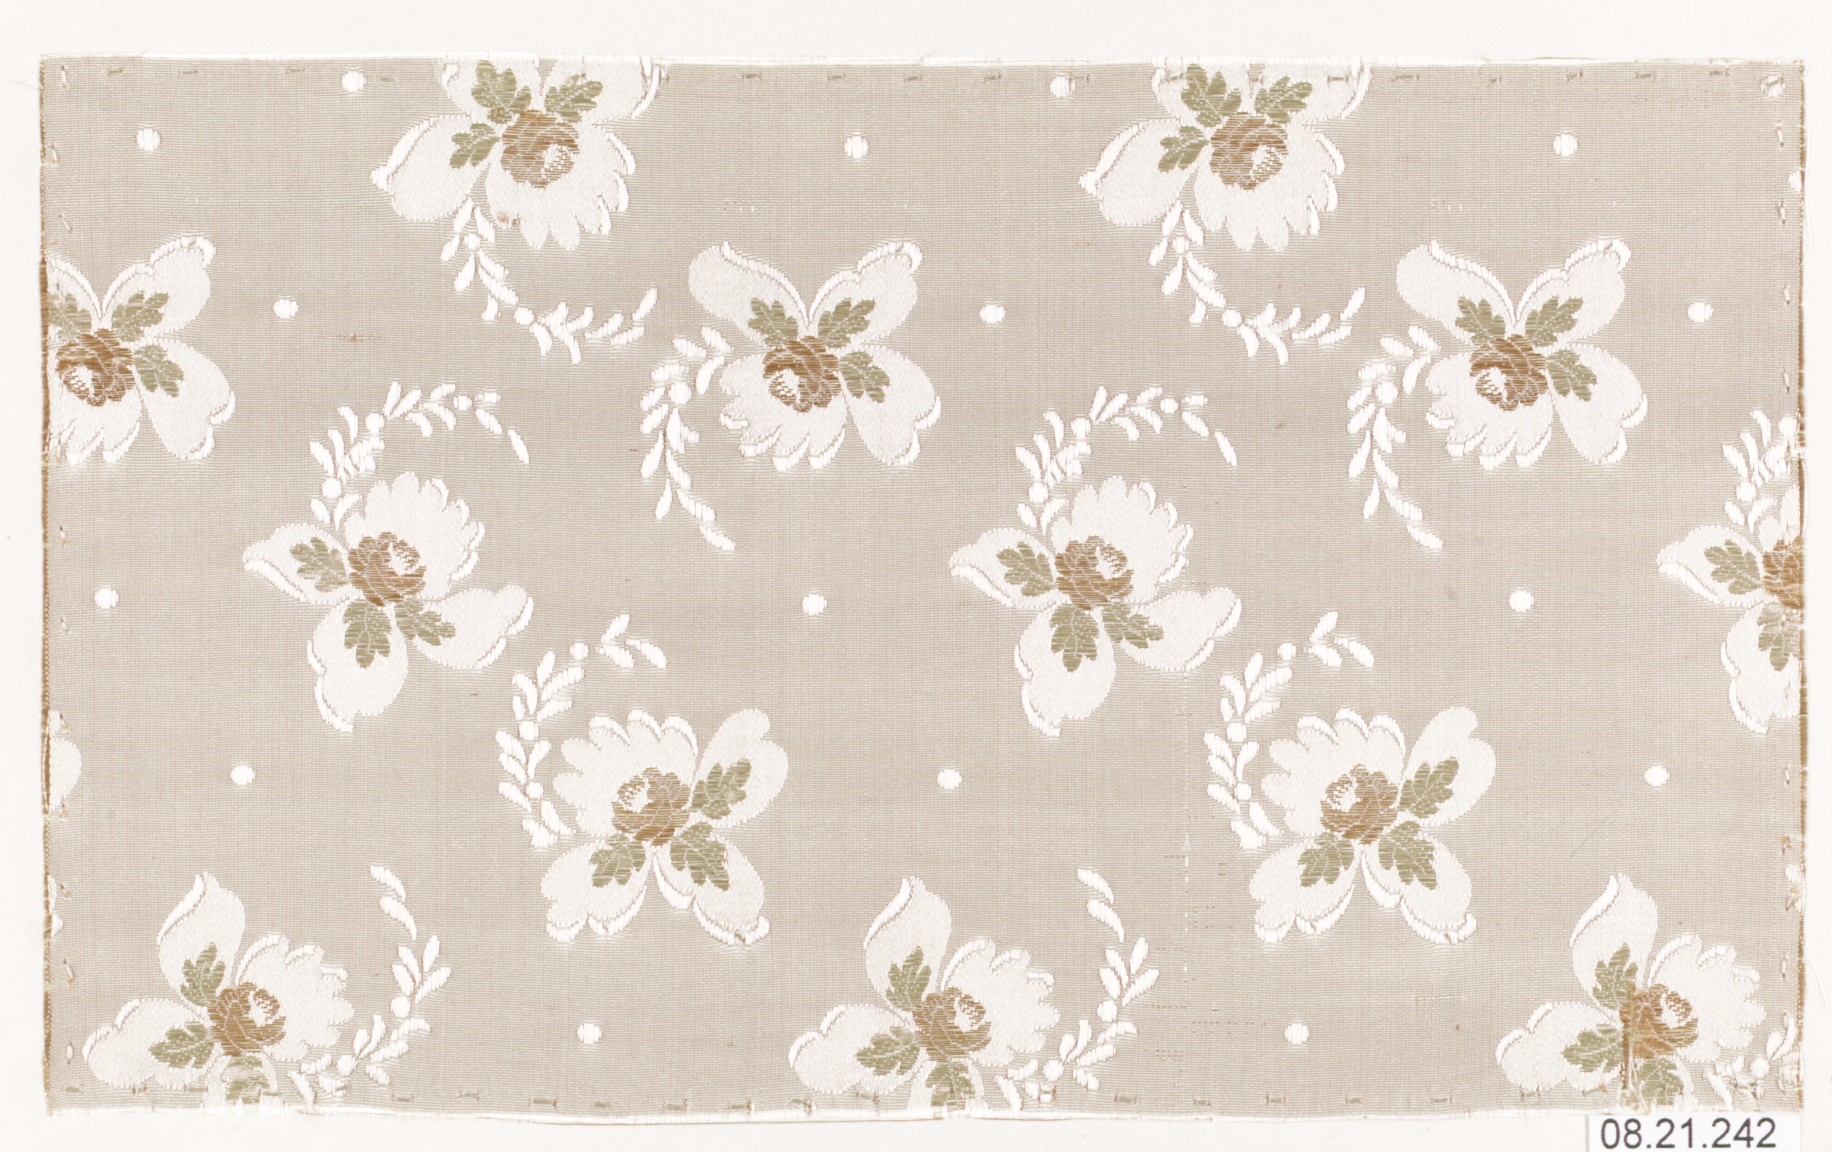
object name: textile sample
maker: Anonymous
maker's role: designer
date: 1900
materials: silk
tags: flowers